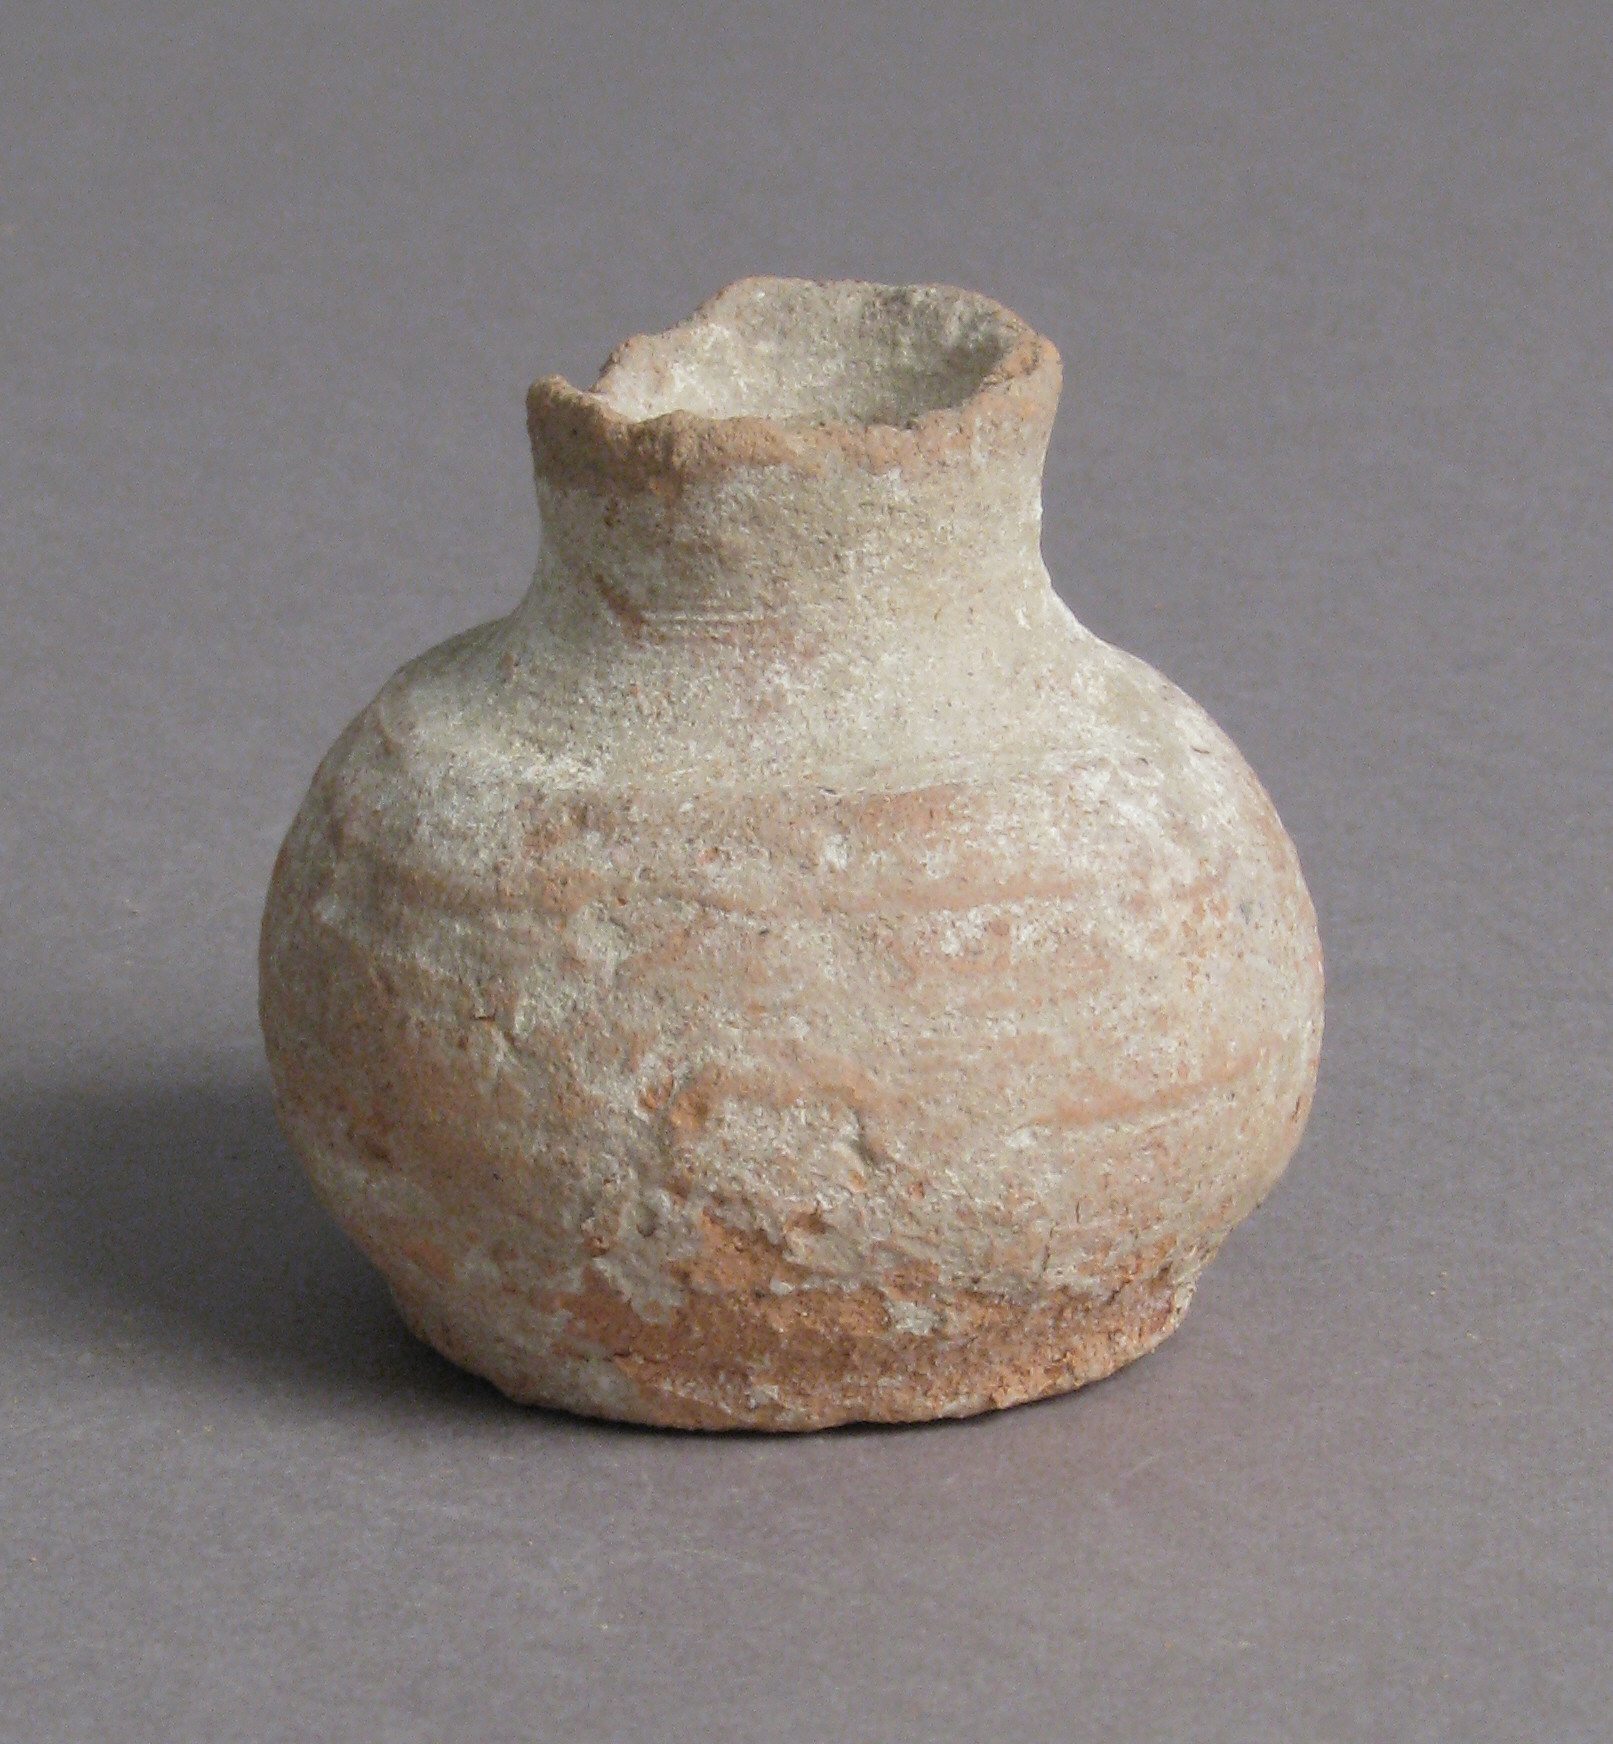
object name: pot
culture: coptic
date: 301-700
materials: earthenware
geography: egypt